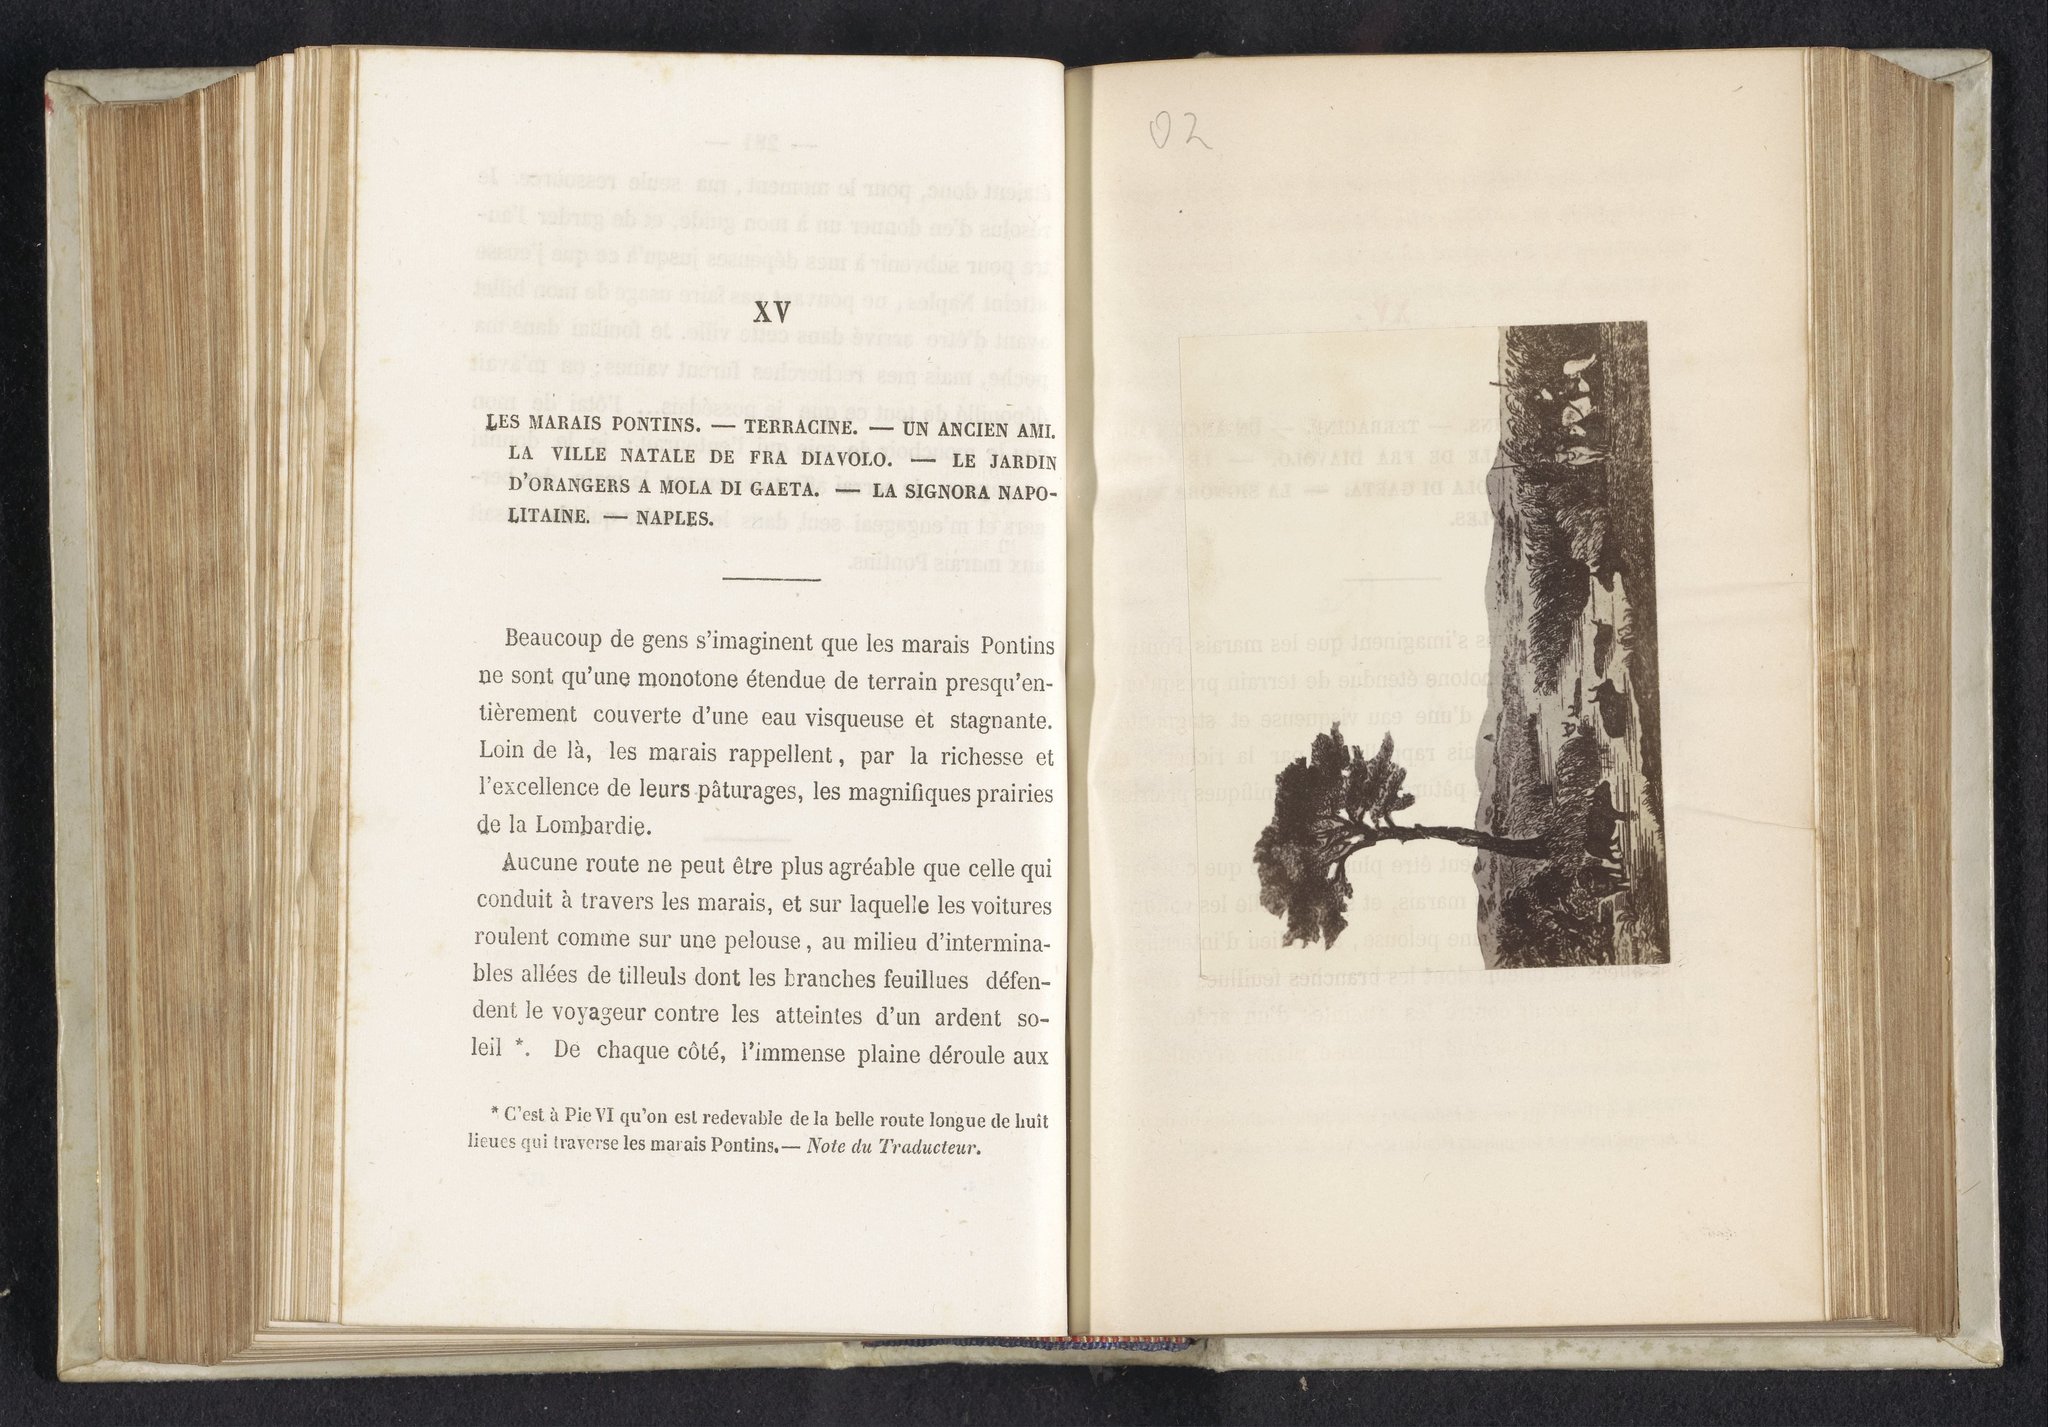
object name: page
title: Fotoreproductie van een tekening, voorstellende een rivier met rundvee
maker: Anonymous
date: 1850-1860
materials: photographic support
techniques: albumen print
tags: river, bovine cattle